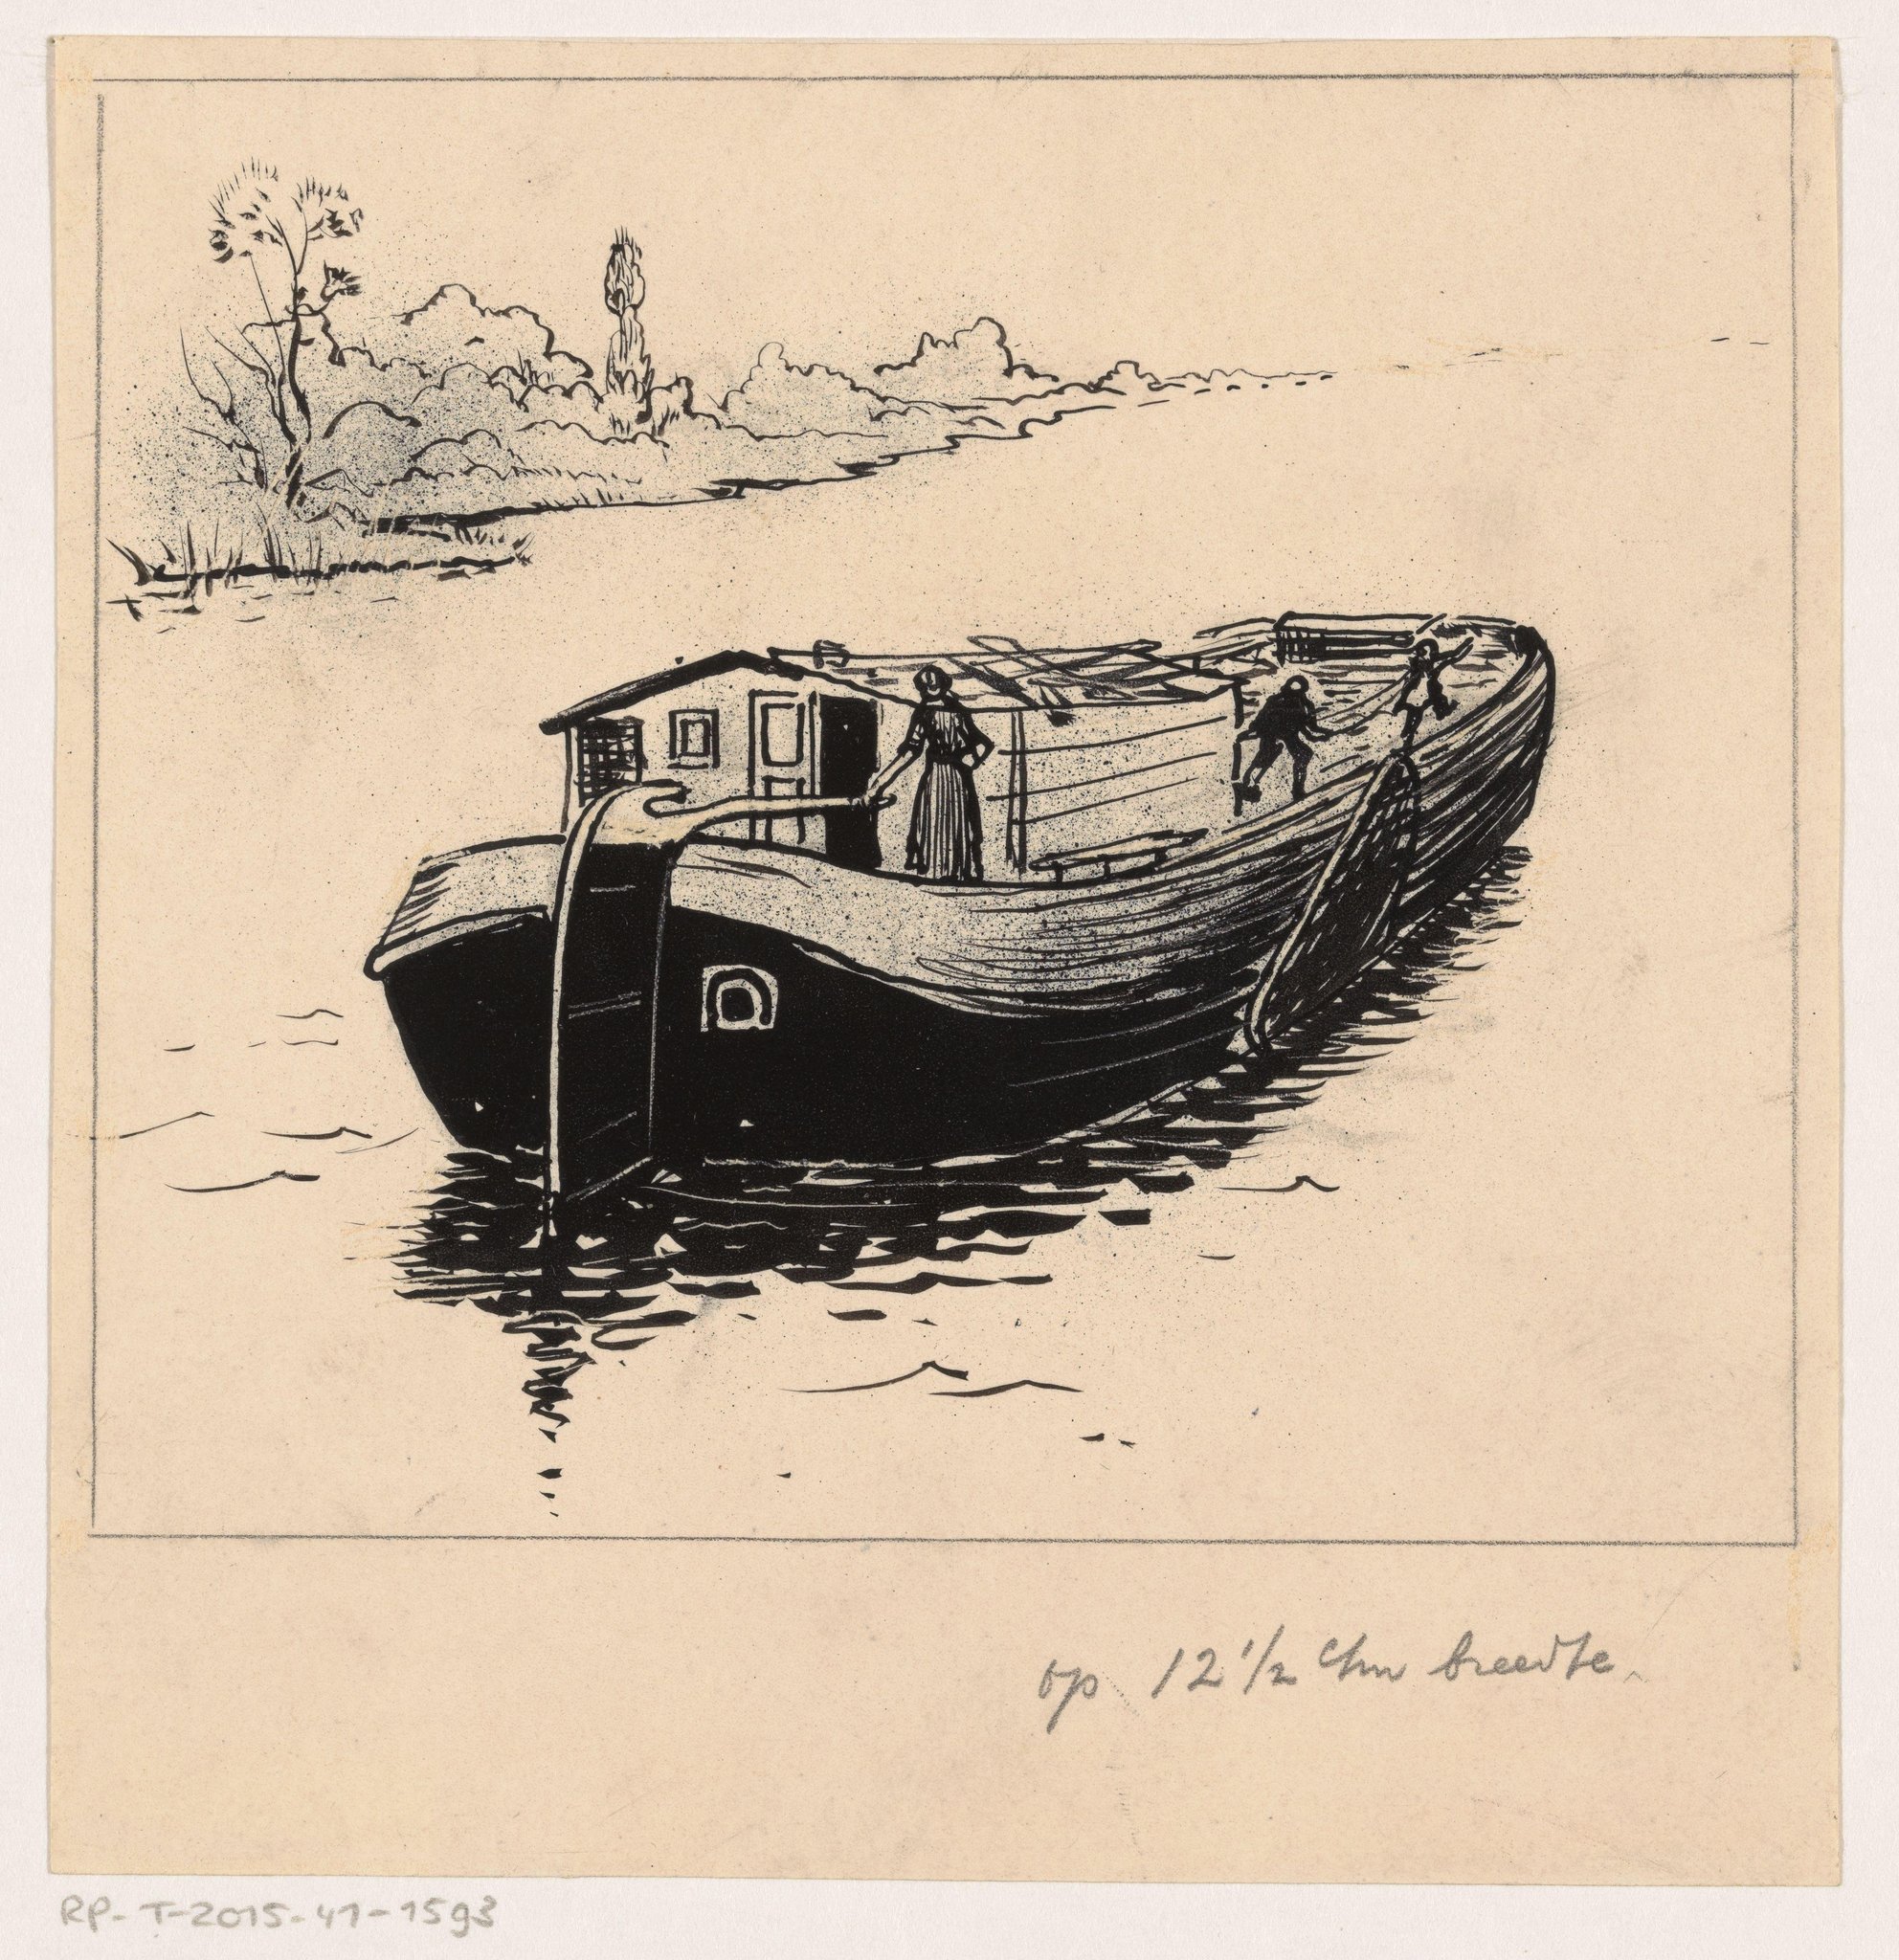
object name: boekillustratie ontwerp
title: Vrouw en kinderen op een boot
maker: elly verstijnen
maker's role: draughtsman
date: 1900-1930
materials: ink, paper, pencil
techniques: brush, pen, spatter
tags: river, boat propelled by man or animal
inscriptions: :, collector's mark: Lugt 2228